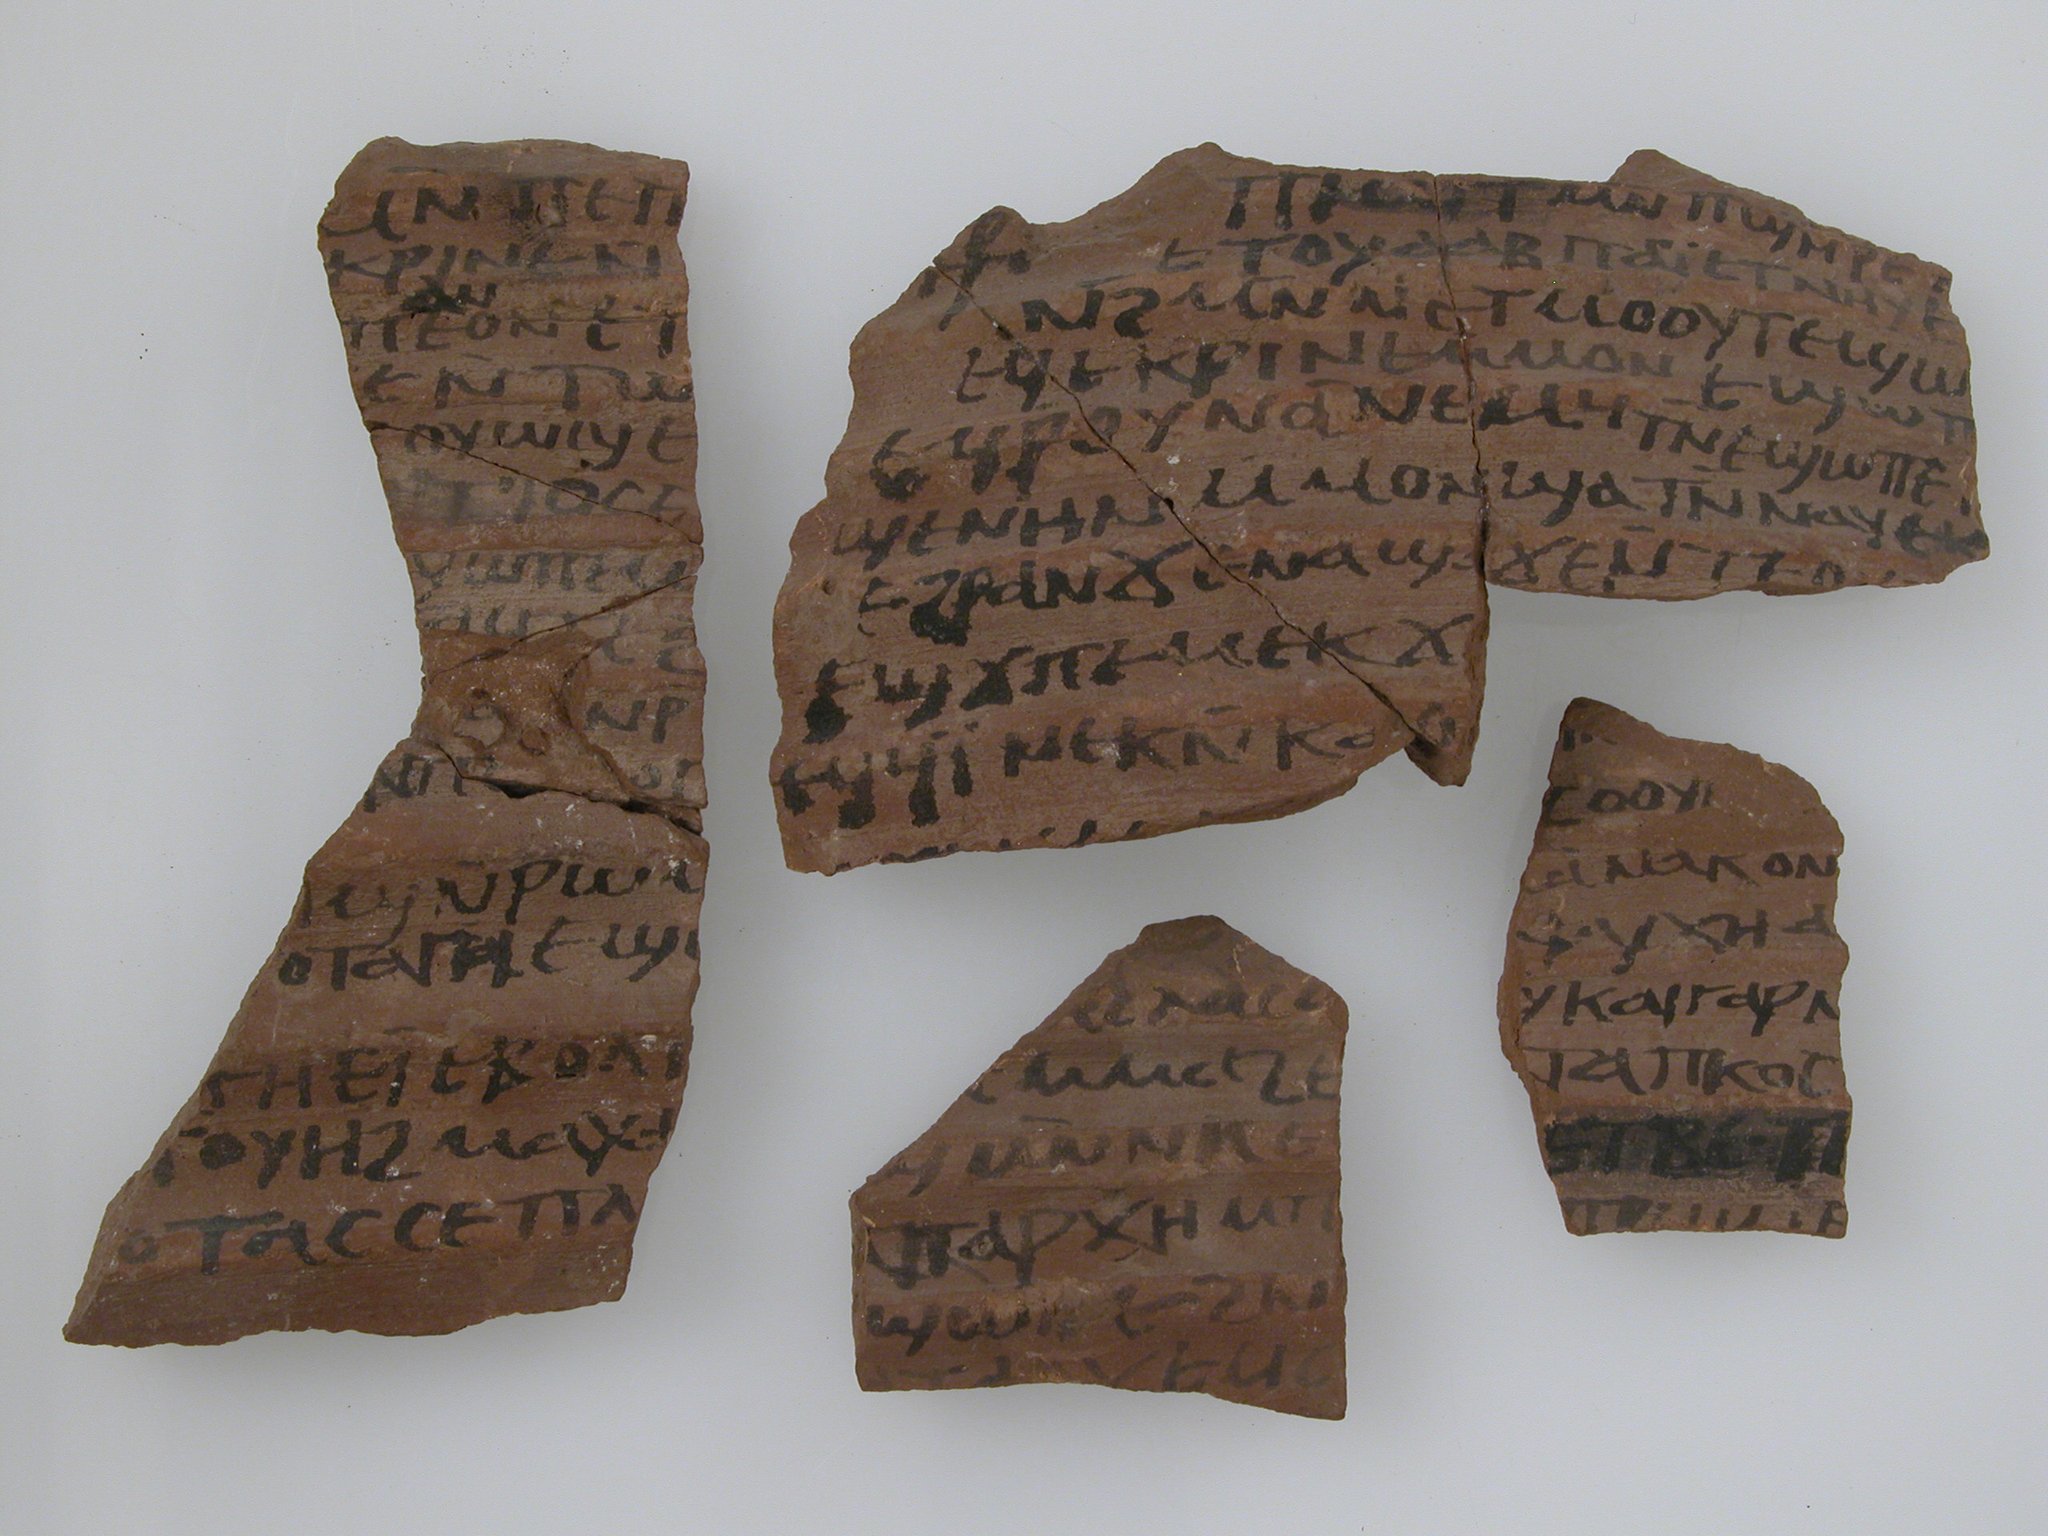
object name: ostrakon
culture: coptic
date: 580-640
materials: ink, pottery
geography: egypt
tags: coptic,documents